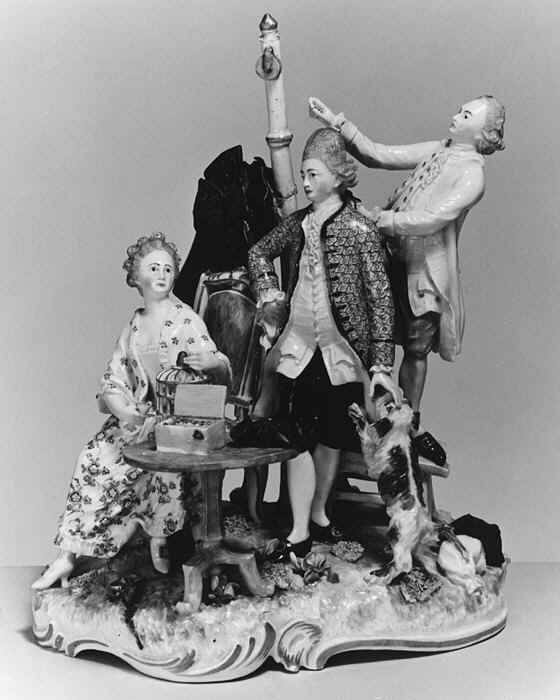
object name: group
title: The Hairdresser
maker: frankenthal porcelain manufactory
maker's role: manufactory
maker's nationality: german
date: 1773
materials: hard paste porcelain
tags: animals,men,women